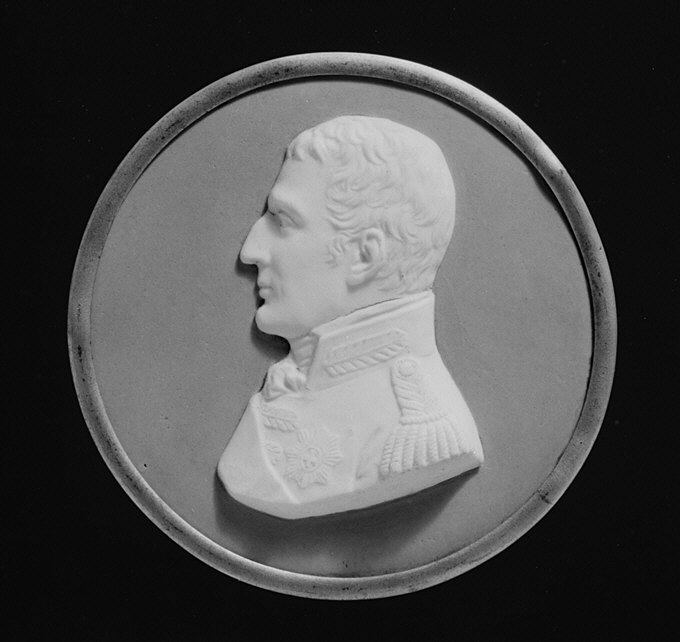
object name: medallion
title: Arthur Wellesley, 1st Duke of Wellington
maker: sèvres manufactory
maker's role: manufactory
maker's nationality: french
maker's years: 1740-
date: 1815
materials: biscuit, paste, porcelain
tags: men,profiles